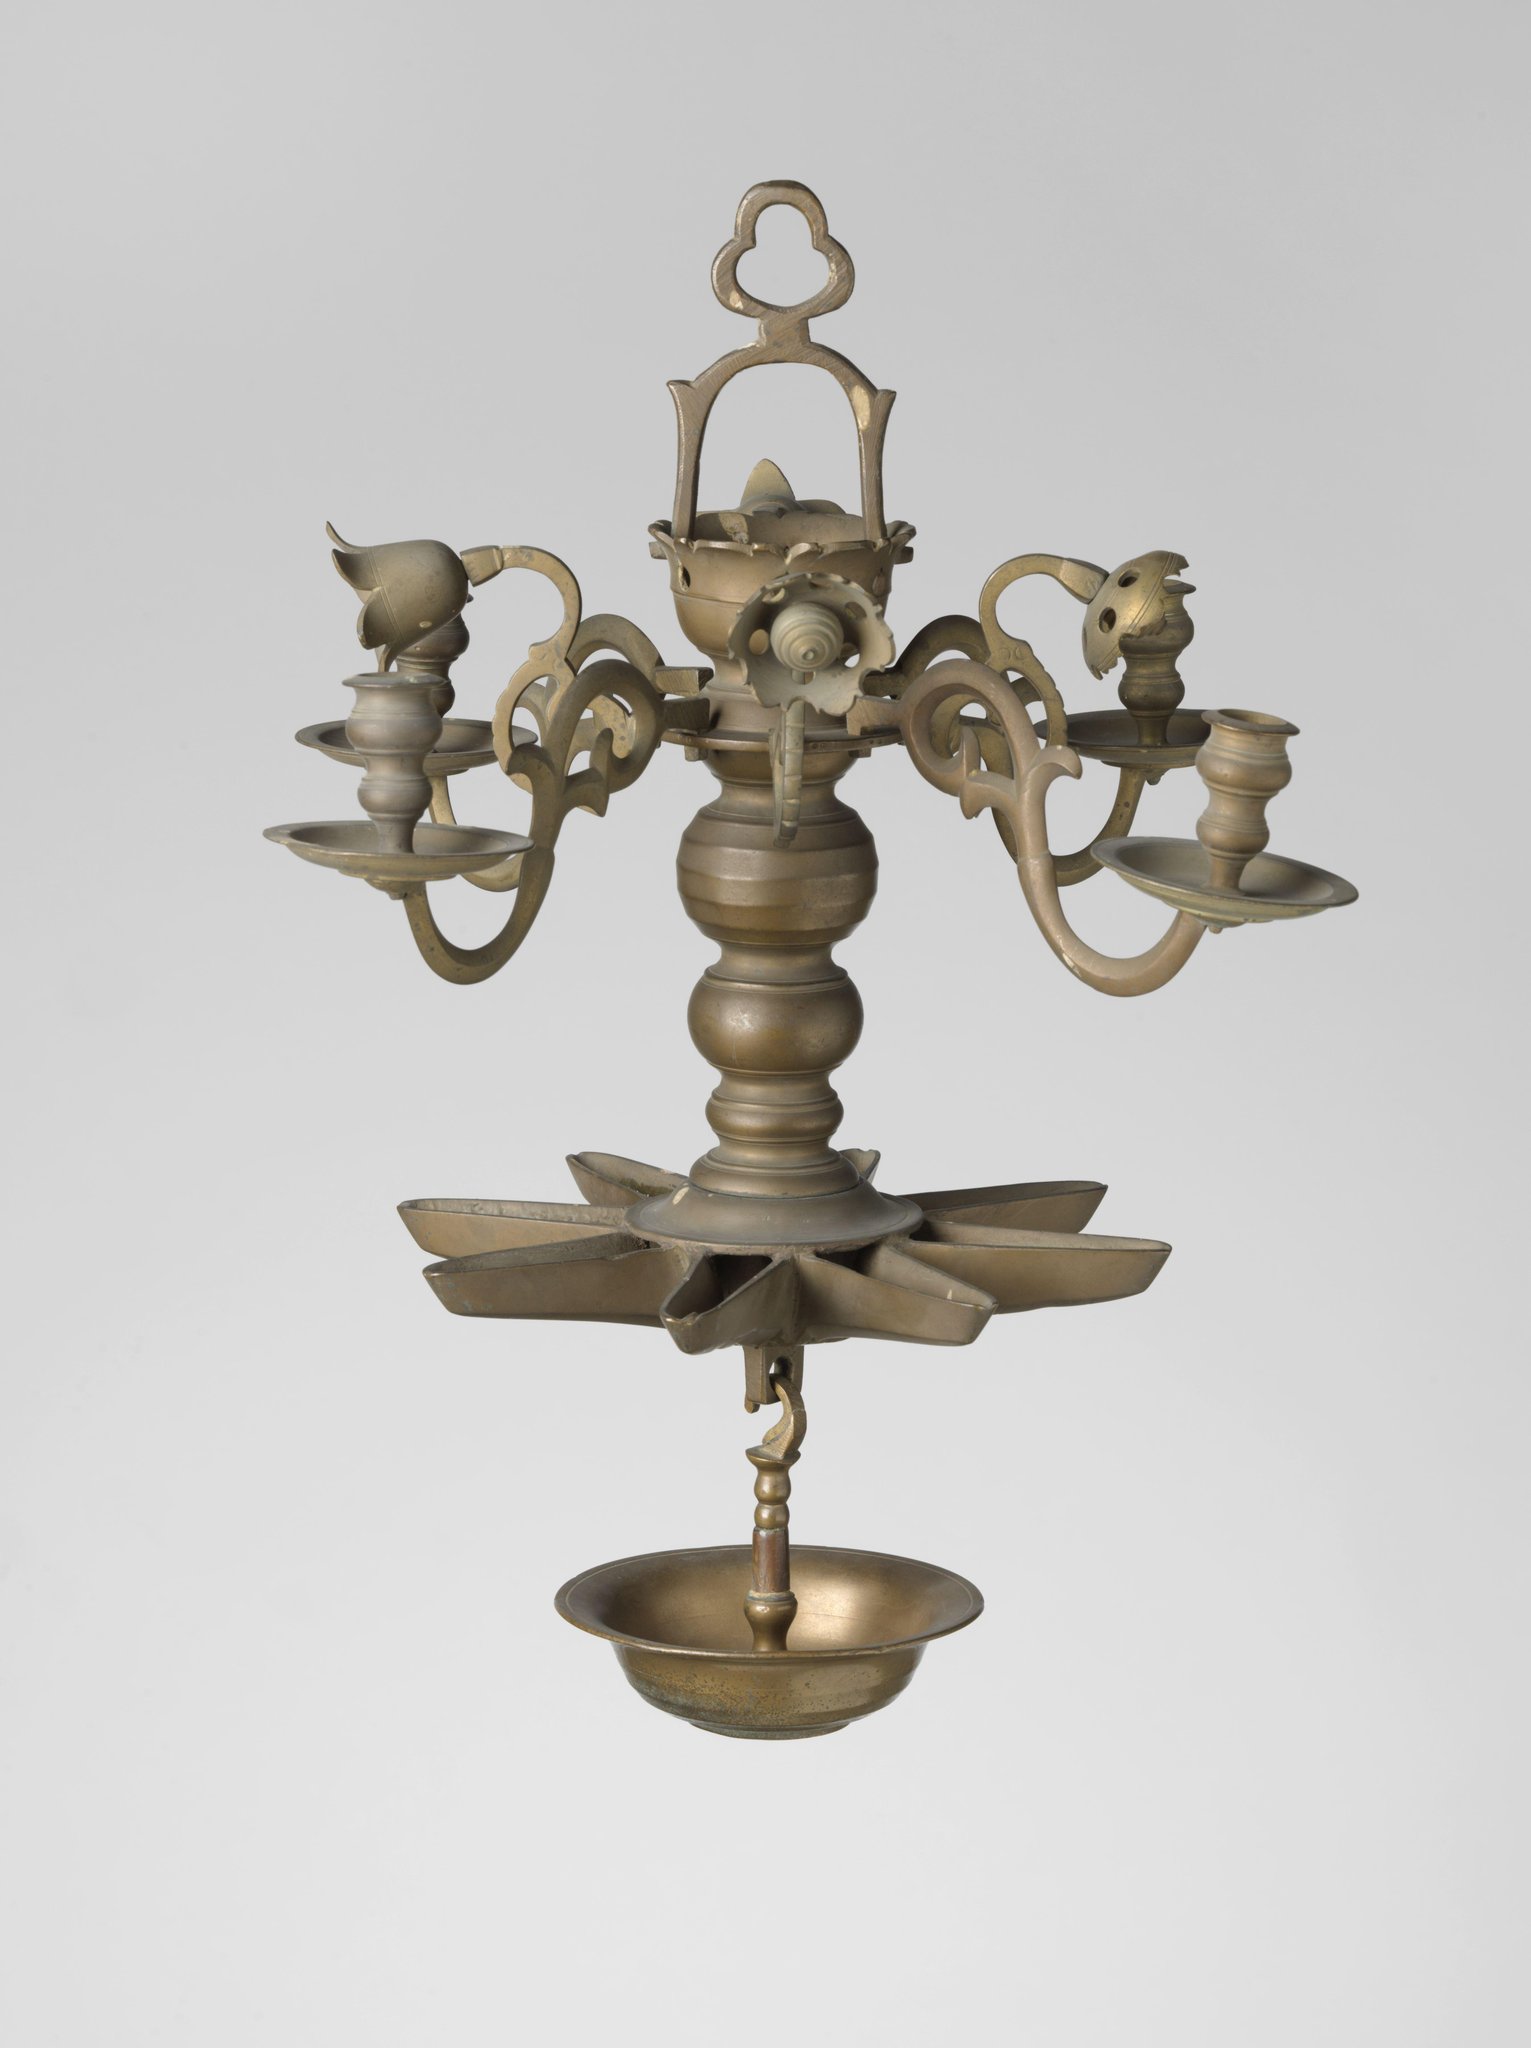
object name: sabbath lamp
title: Stam van een sabbathlamp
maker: Anonymous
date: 1700-1800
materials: brass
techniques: casting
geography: nuremberg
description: Het voorwerp bestaat uit de volgende gegoten delen: het hengsel, de stam, de oliebak. Het hengsel heeft bovenaan een klaverbladvormig oog. De geprofileerde naar beneden toe versmallende stam is bovenaan kelkvormig, heeft vervolgens een standring met vier gaten en vier inkepingen (ter bevestiging van de armen en de sierelementen) en is daarna drie keer bolvormig geprofileerd. De achtpuntige stervormige oliebak, die aan de onderkant rond het oog een ingeslagen ornament heeft, is met een bajonetsluiting aan de stam bevestigd. De gaten en inkepingen zijn ongenummerd, dan wel genummerd met 1 t/m 3 punten.